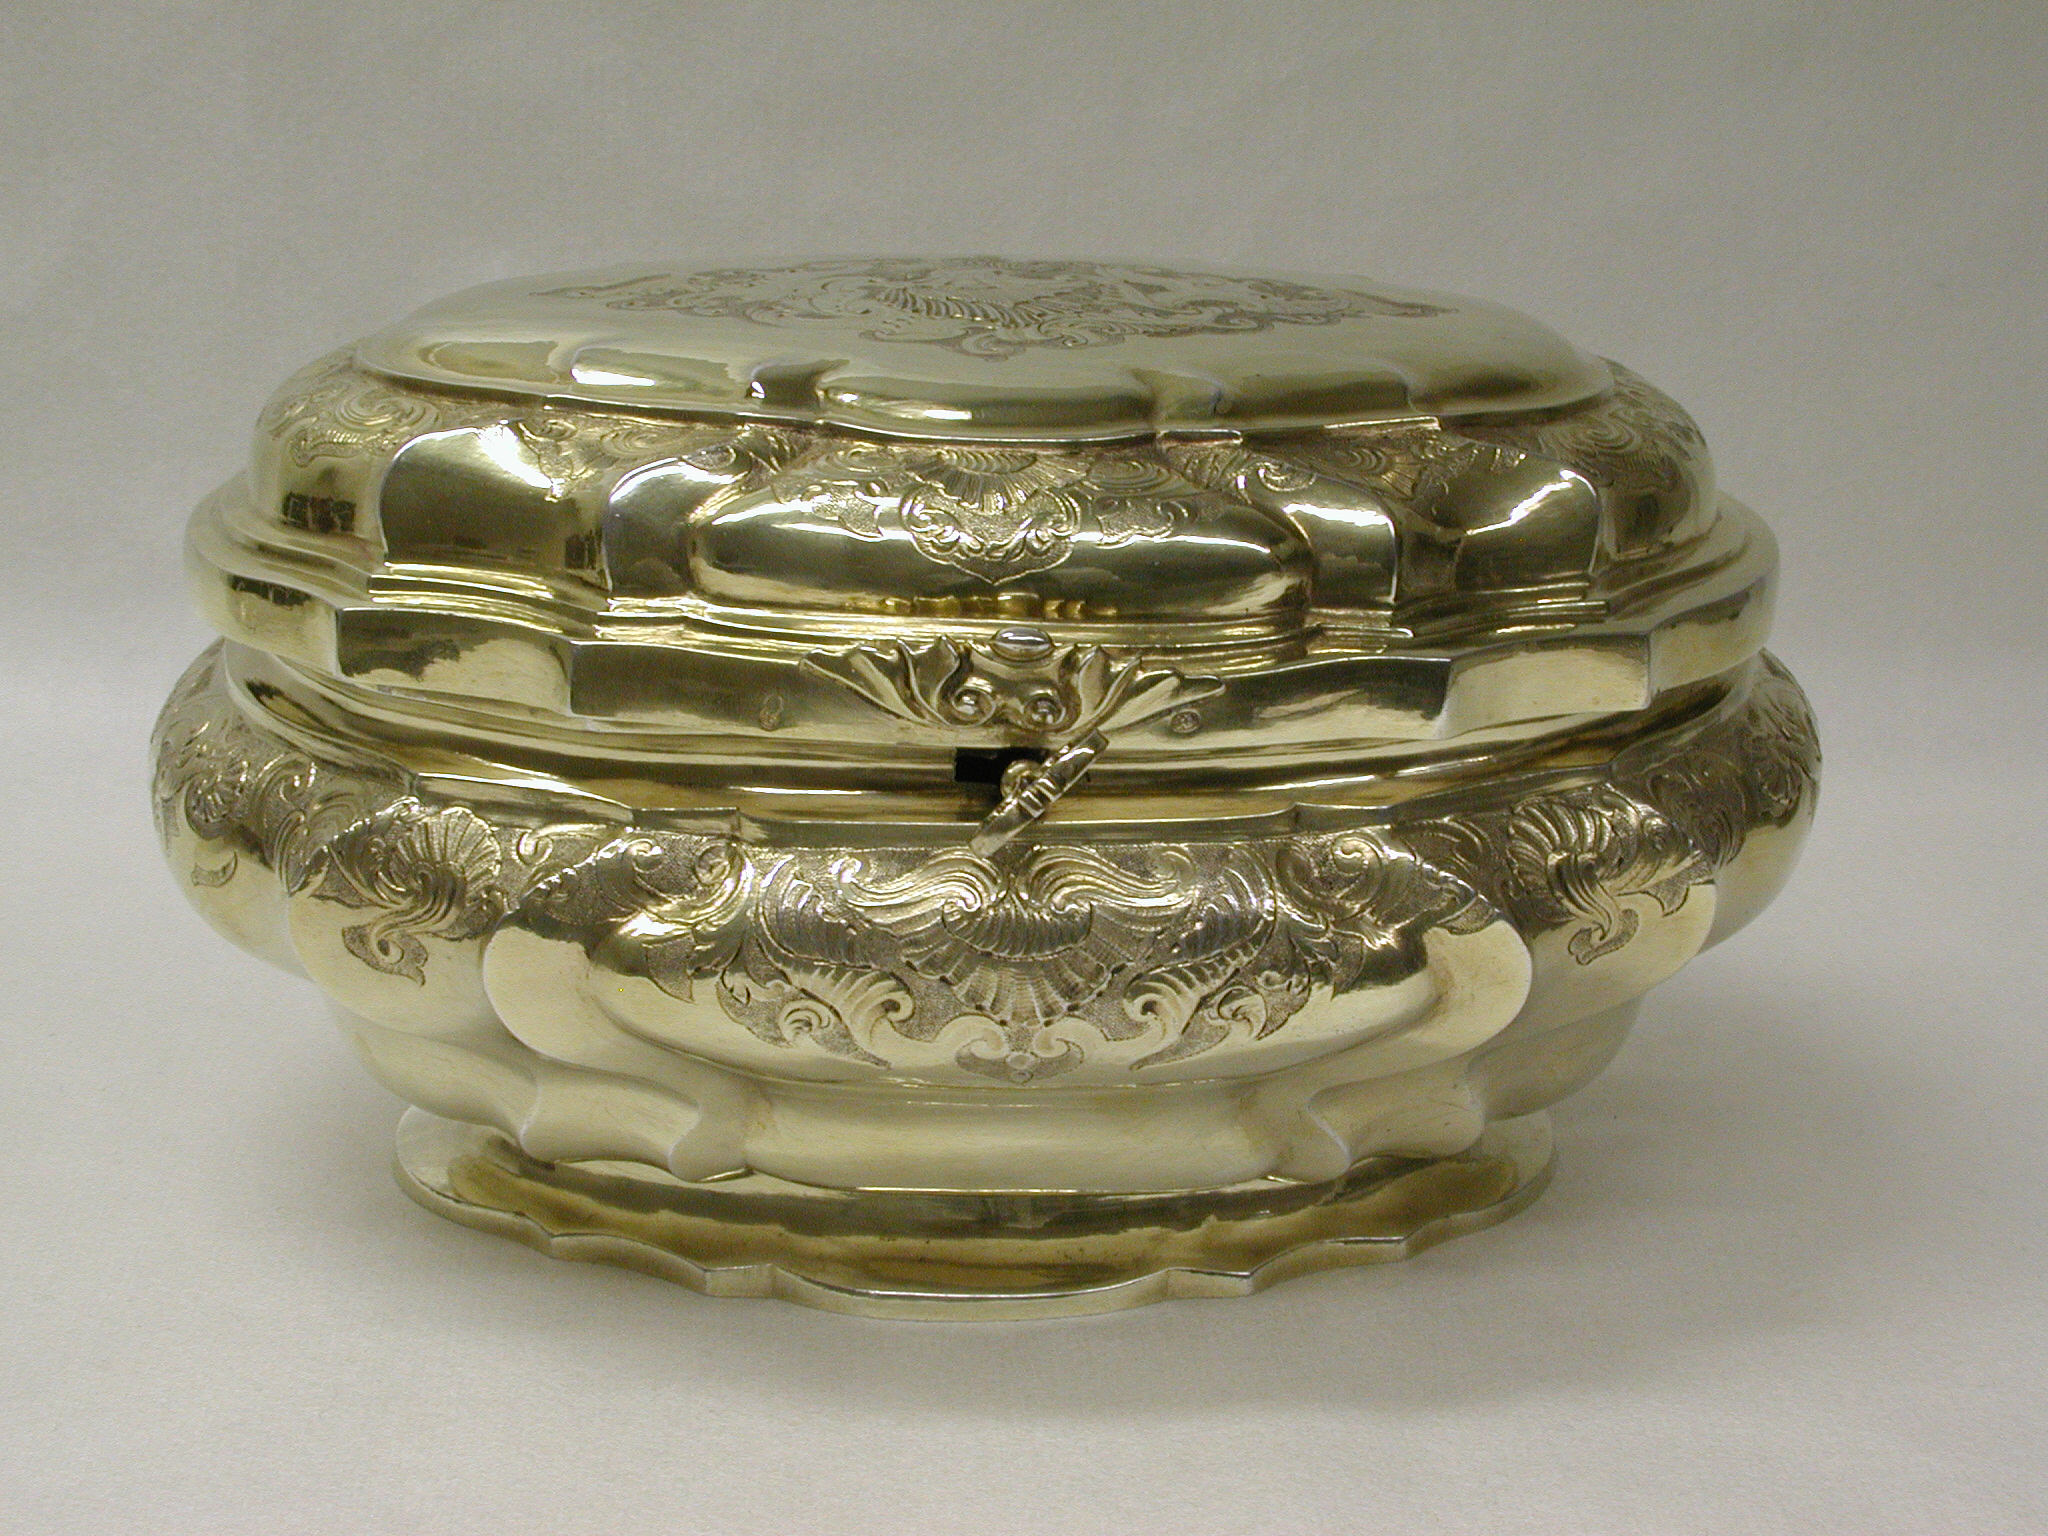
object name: toilet box with key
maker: friedrich schwestermuller ii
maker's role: maker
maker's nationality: german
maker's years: 1713-1752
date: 1743-1745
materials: silver gilt